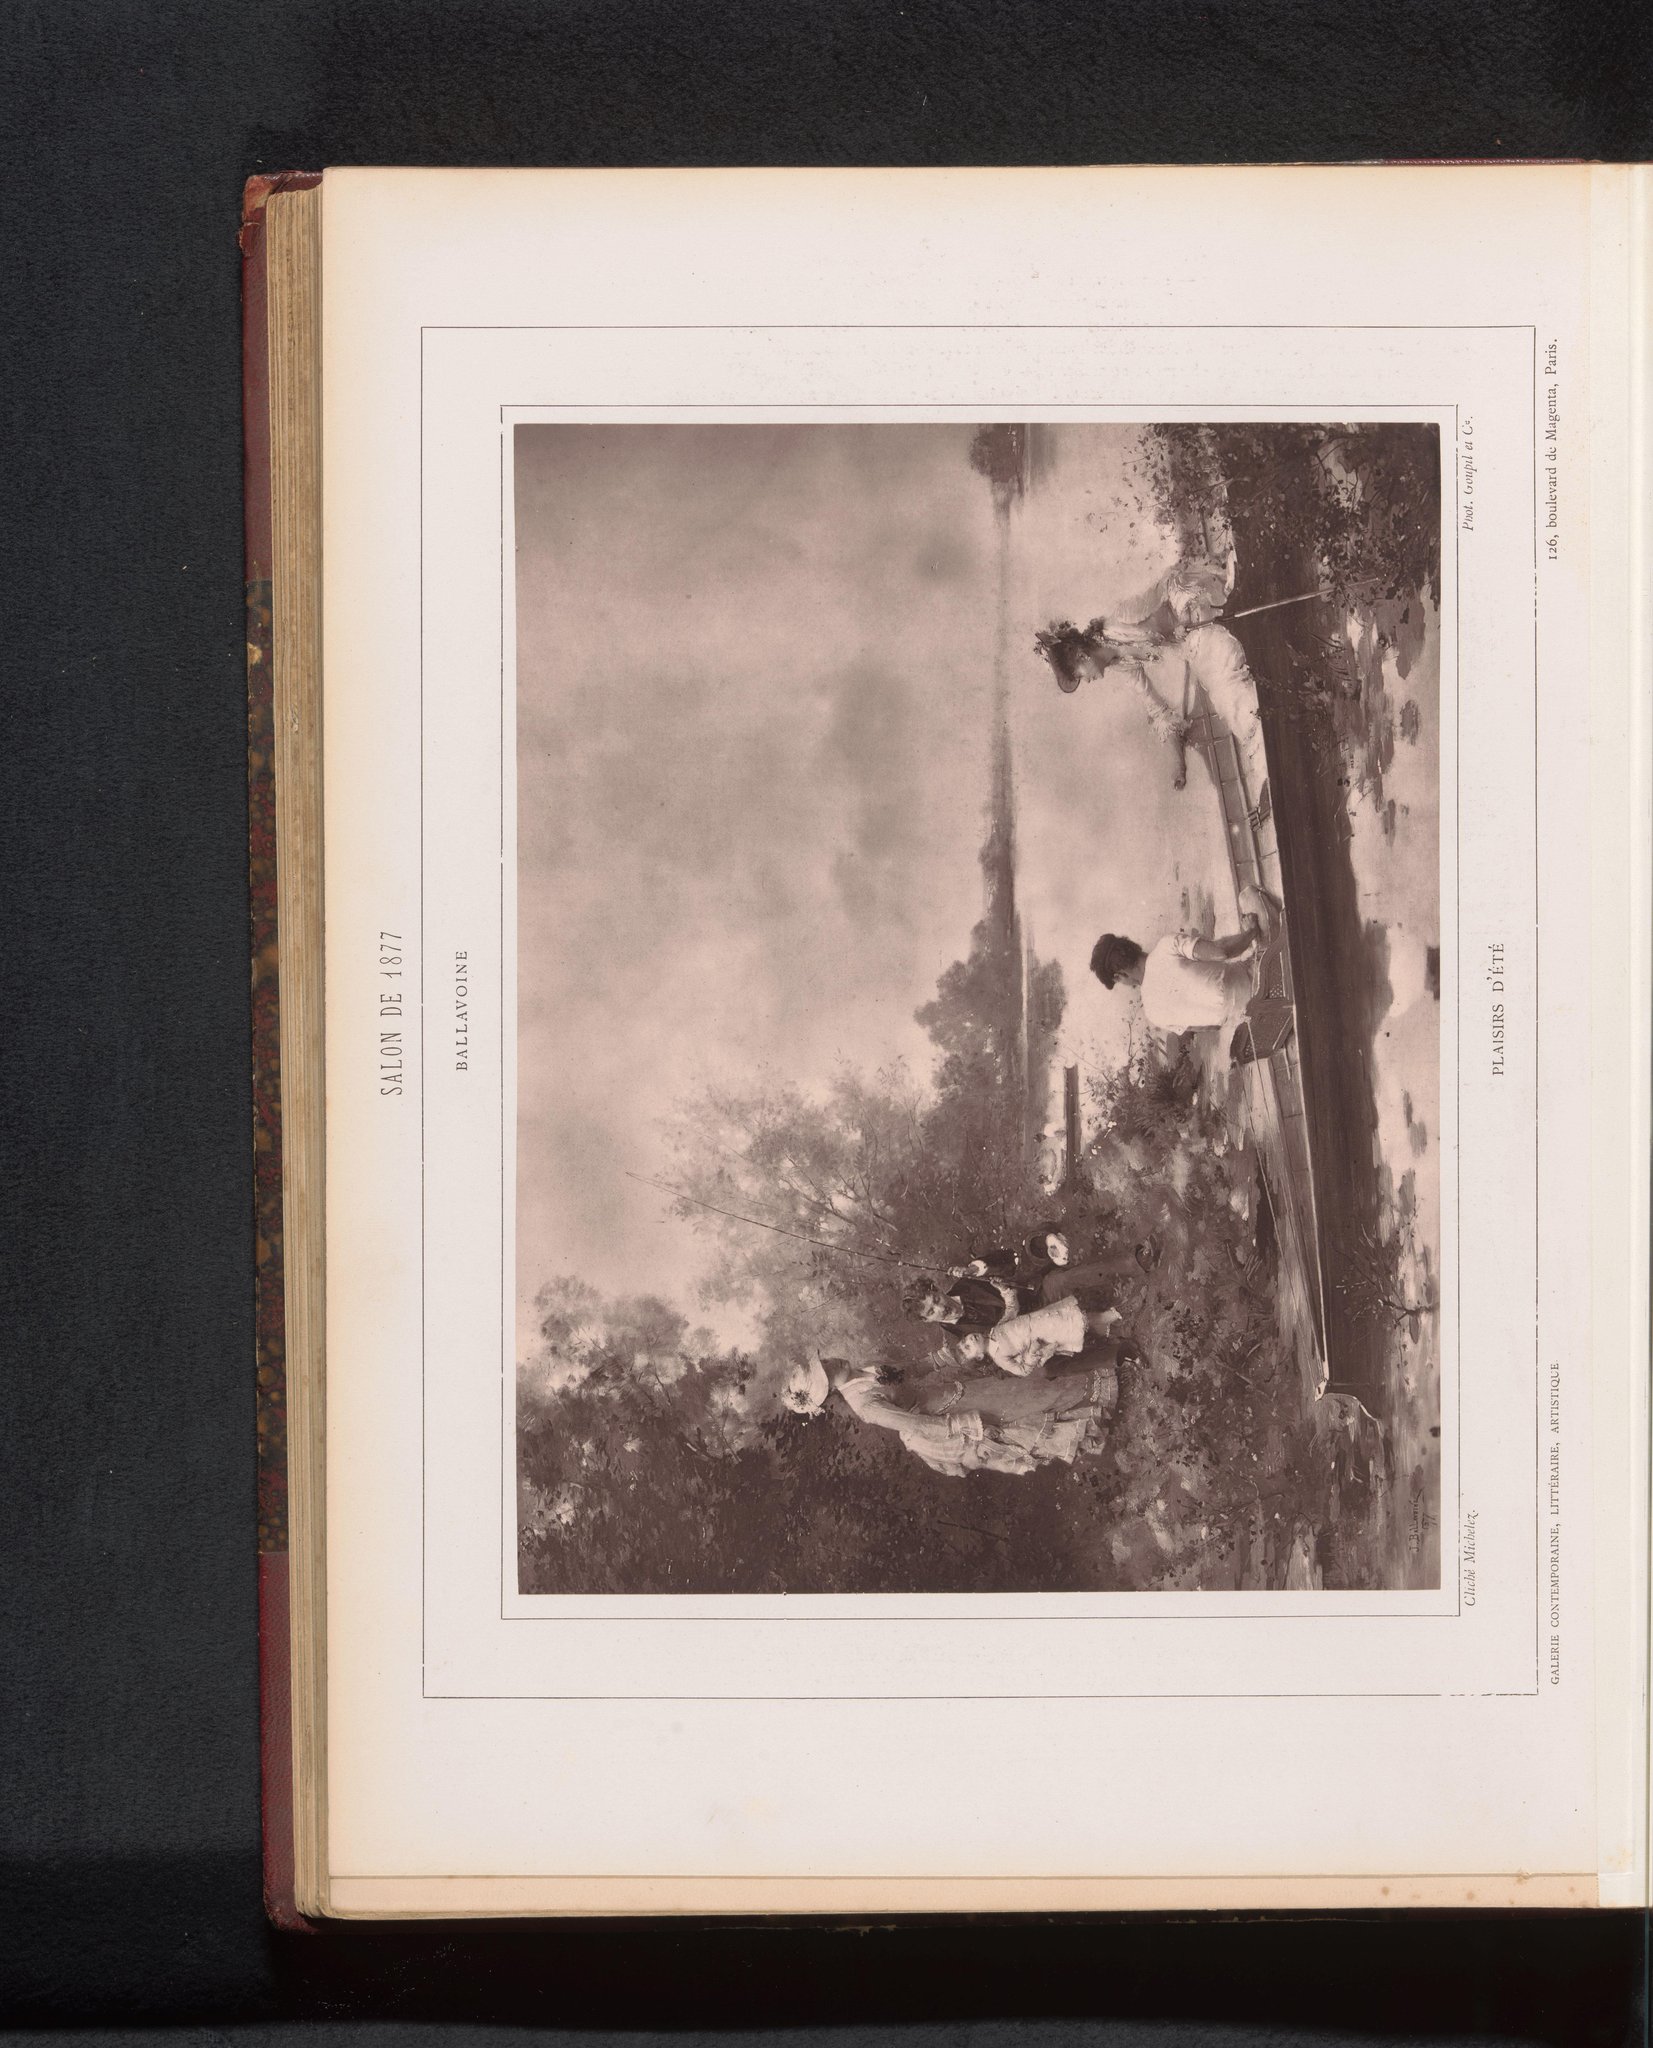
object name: page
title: Plaisirs d'été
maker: charles michelez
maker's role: fotograaf, fotostudio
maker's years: 1817-1883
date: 1872-1877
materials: paper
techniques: woodburytype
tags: historical persons, landscapes with waters, waterscapes, seascapes (in the temperate zone), rowing-boat, canoe, etc., painting, drawing and the graphic arts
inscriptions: inscription: ‘Galerie Contemporaine, Littéraire, Artistique/ 126, boulevard de Magenta, Paris.’